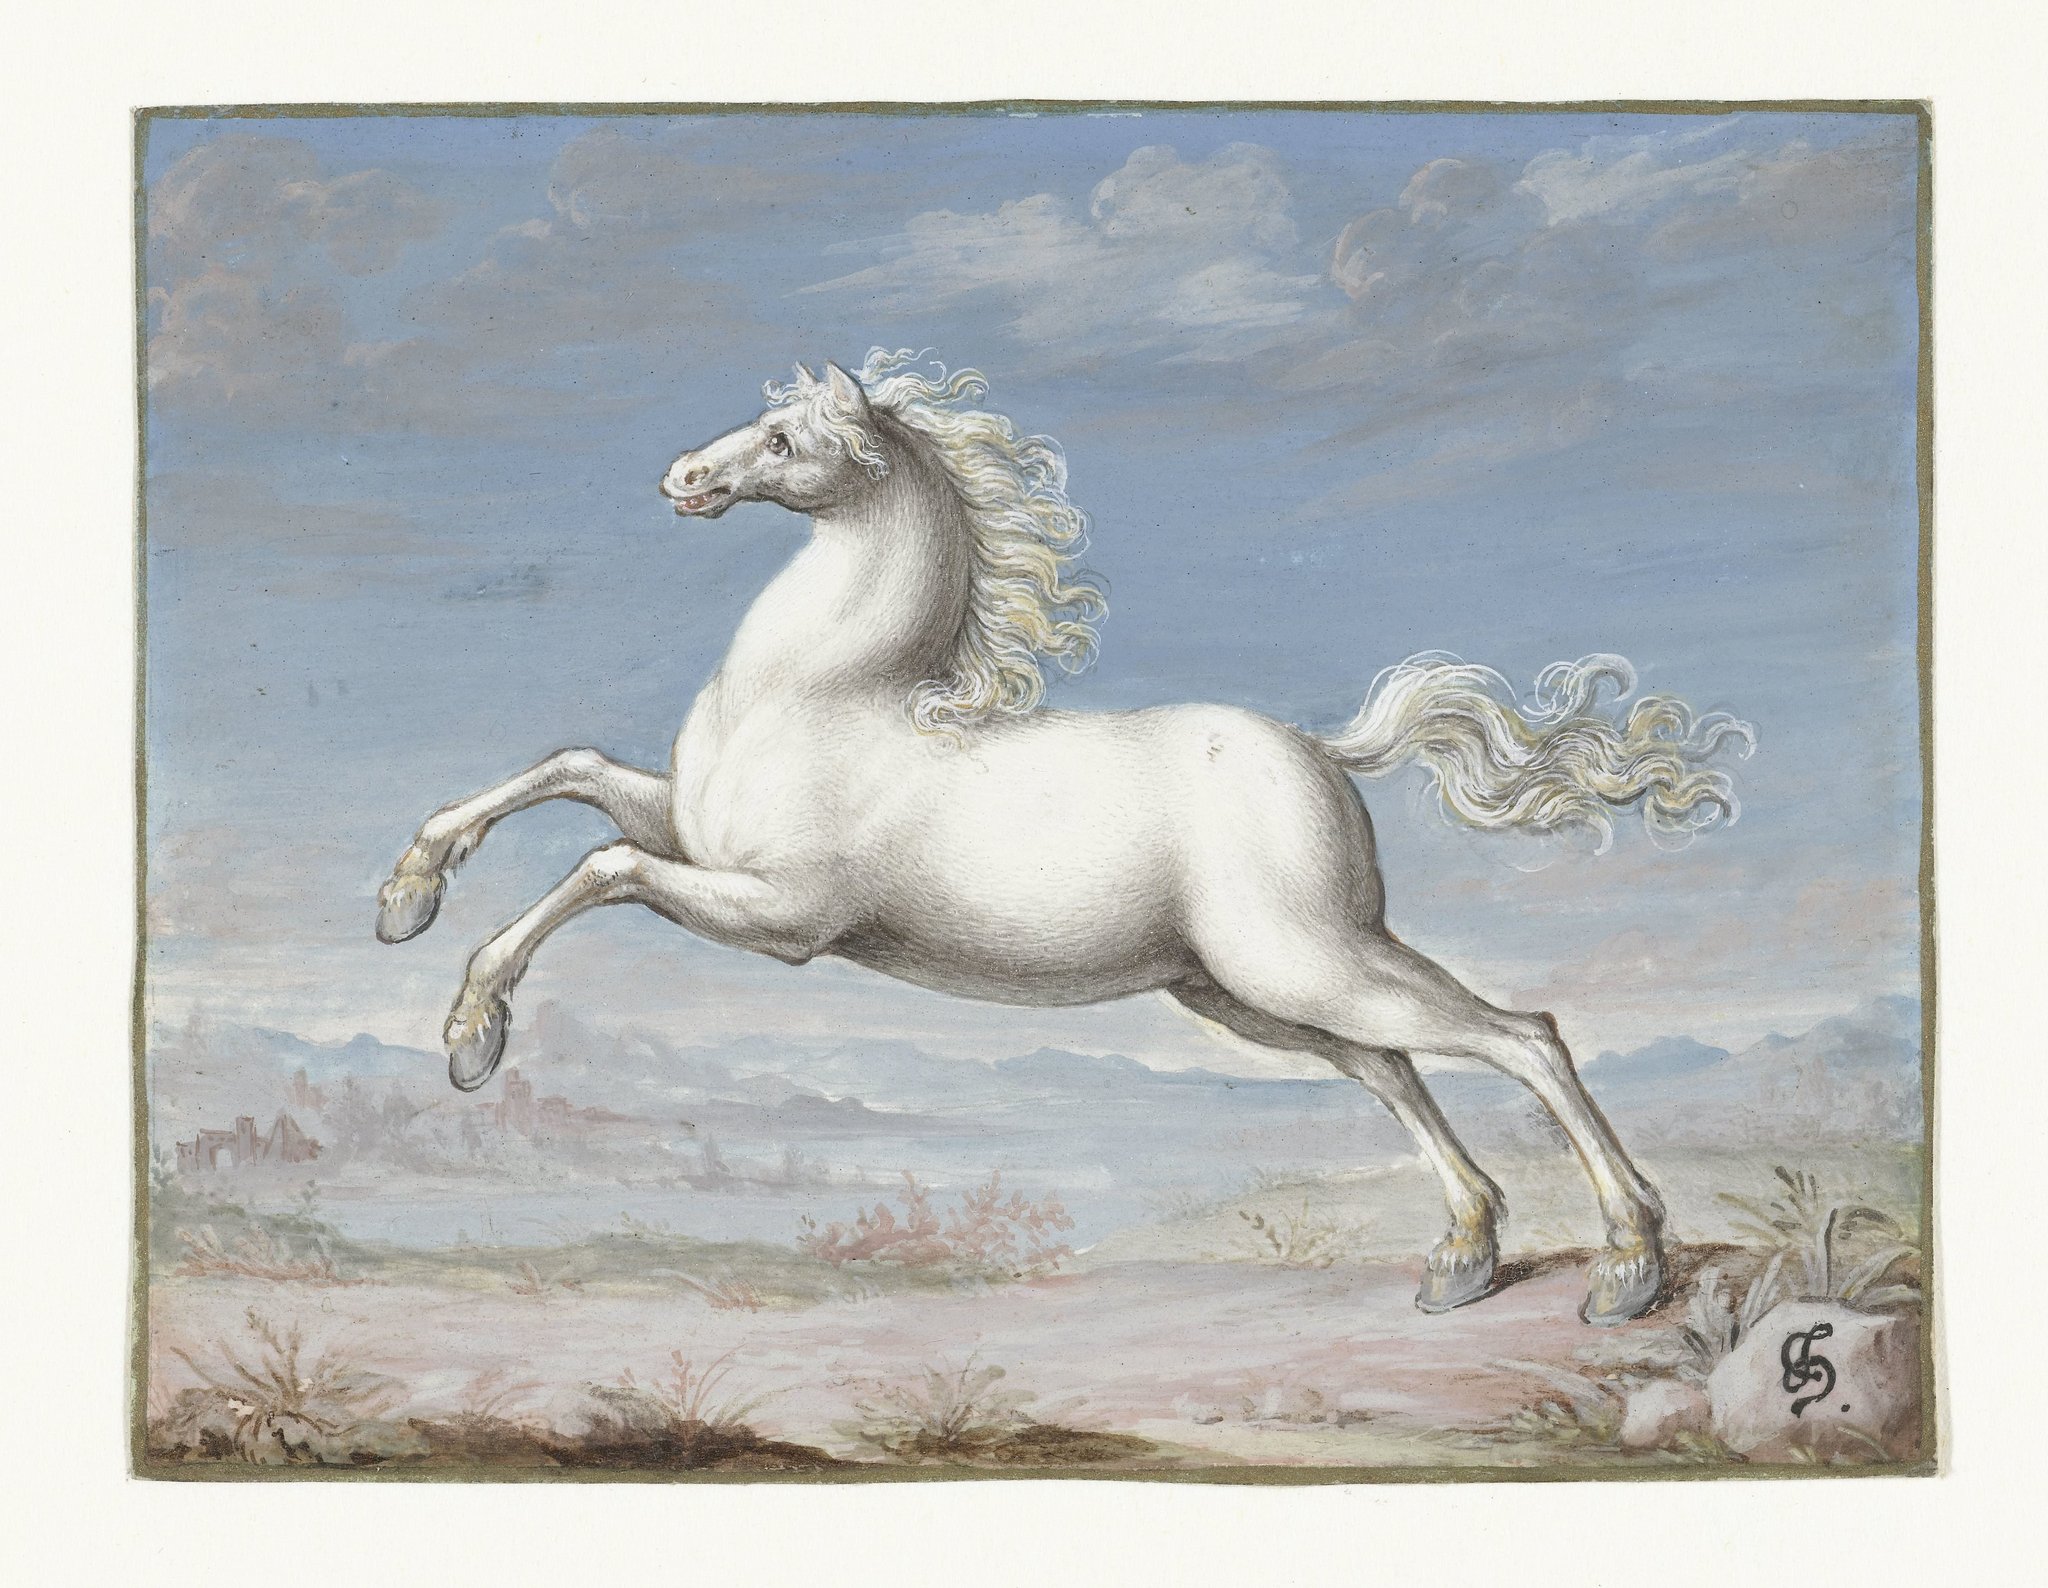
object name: drawing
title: Wit paard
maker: joris hoefnagel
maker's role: draughtsman, painter, print maker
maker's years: 1542-1600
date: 1552-1601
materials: gouache, parchment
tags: horses and kindred animals